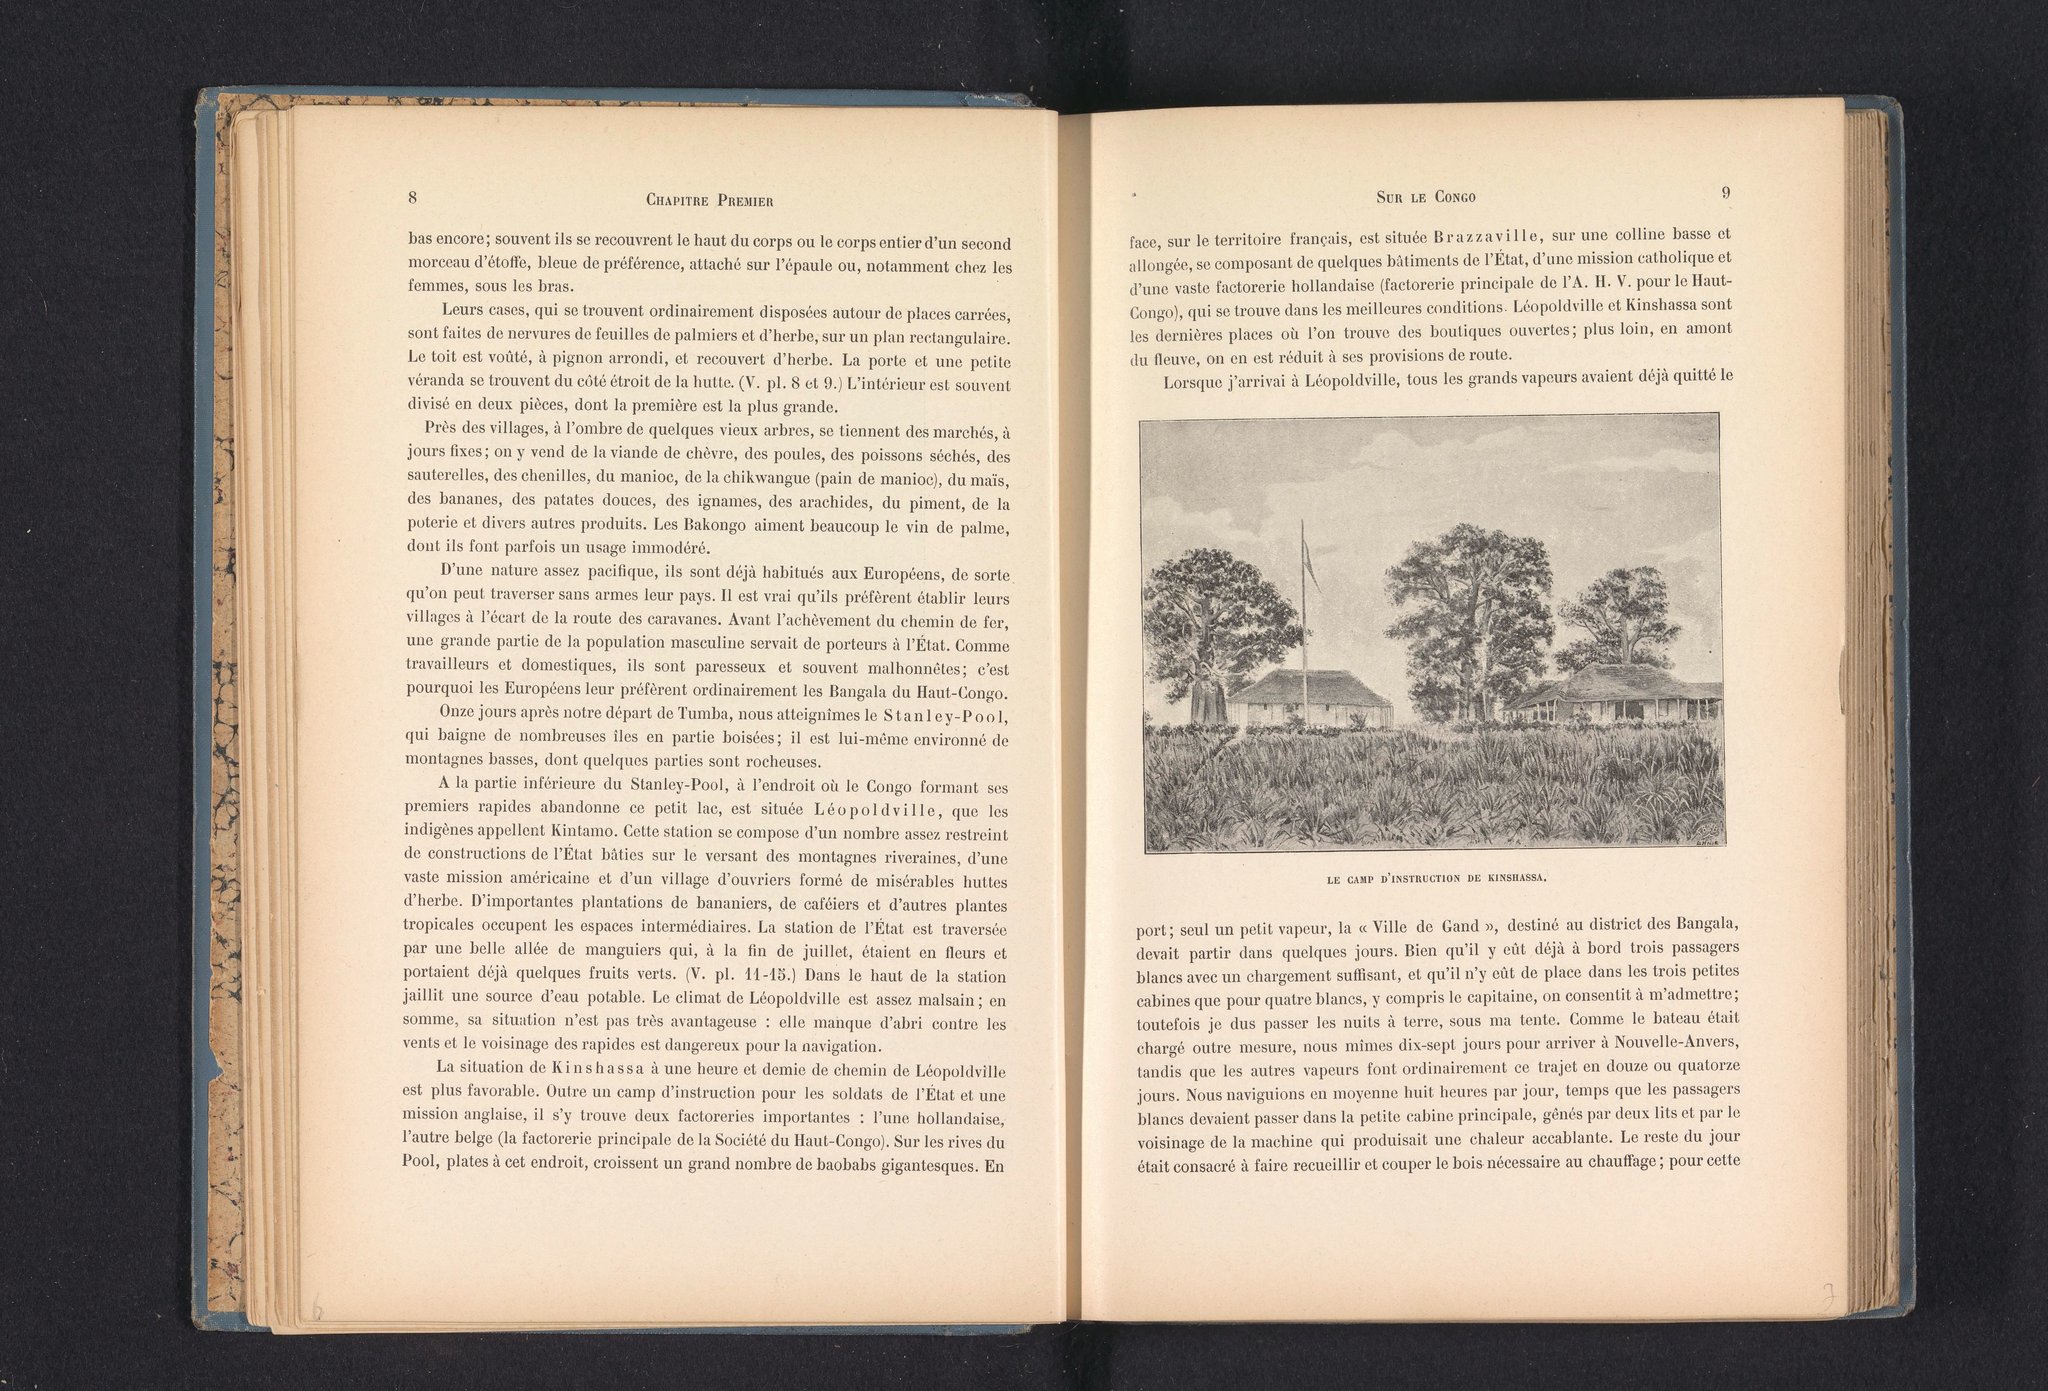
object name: photomechanical print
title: Fotoreproductie van een tekening, voorstellende een militair instructiekamp te Kinshasa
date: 1896-1899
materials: paper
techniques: autotype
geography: dresden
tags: barracks